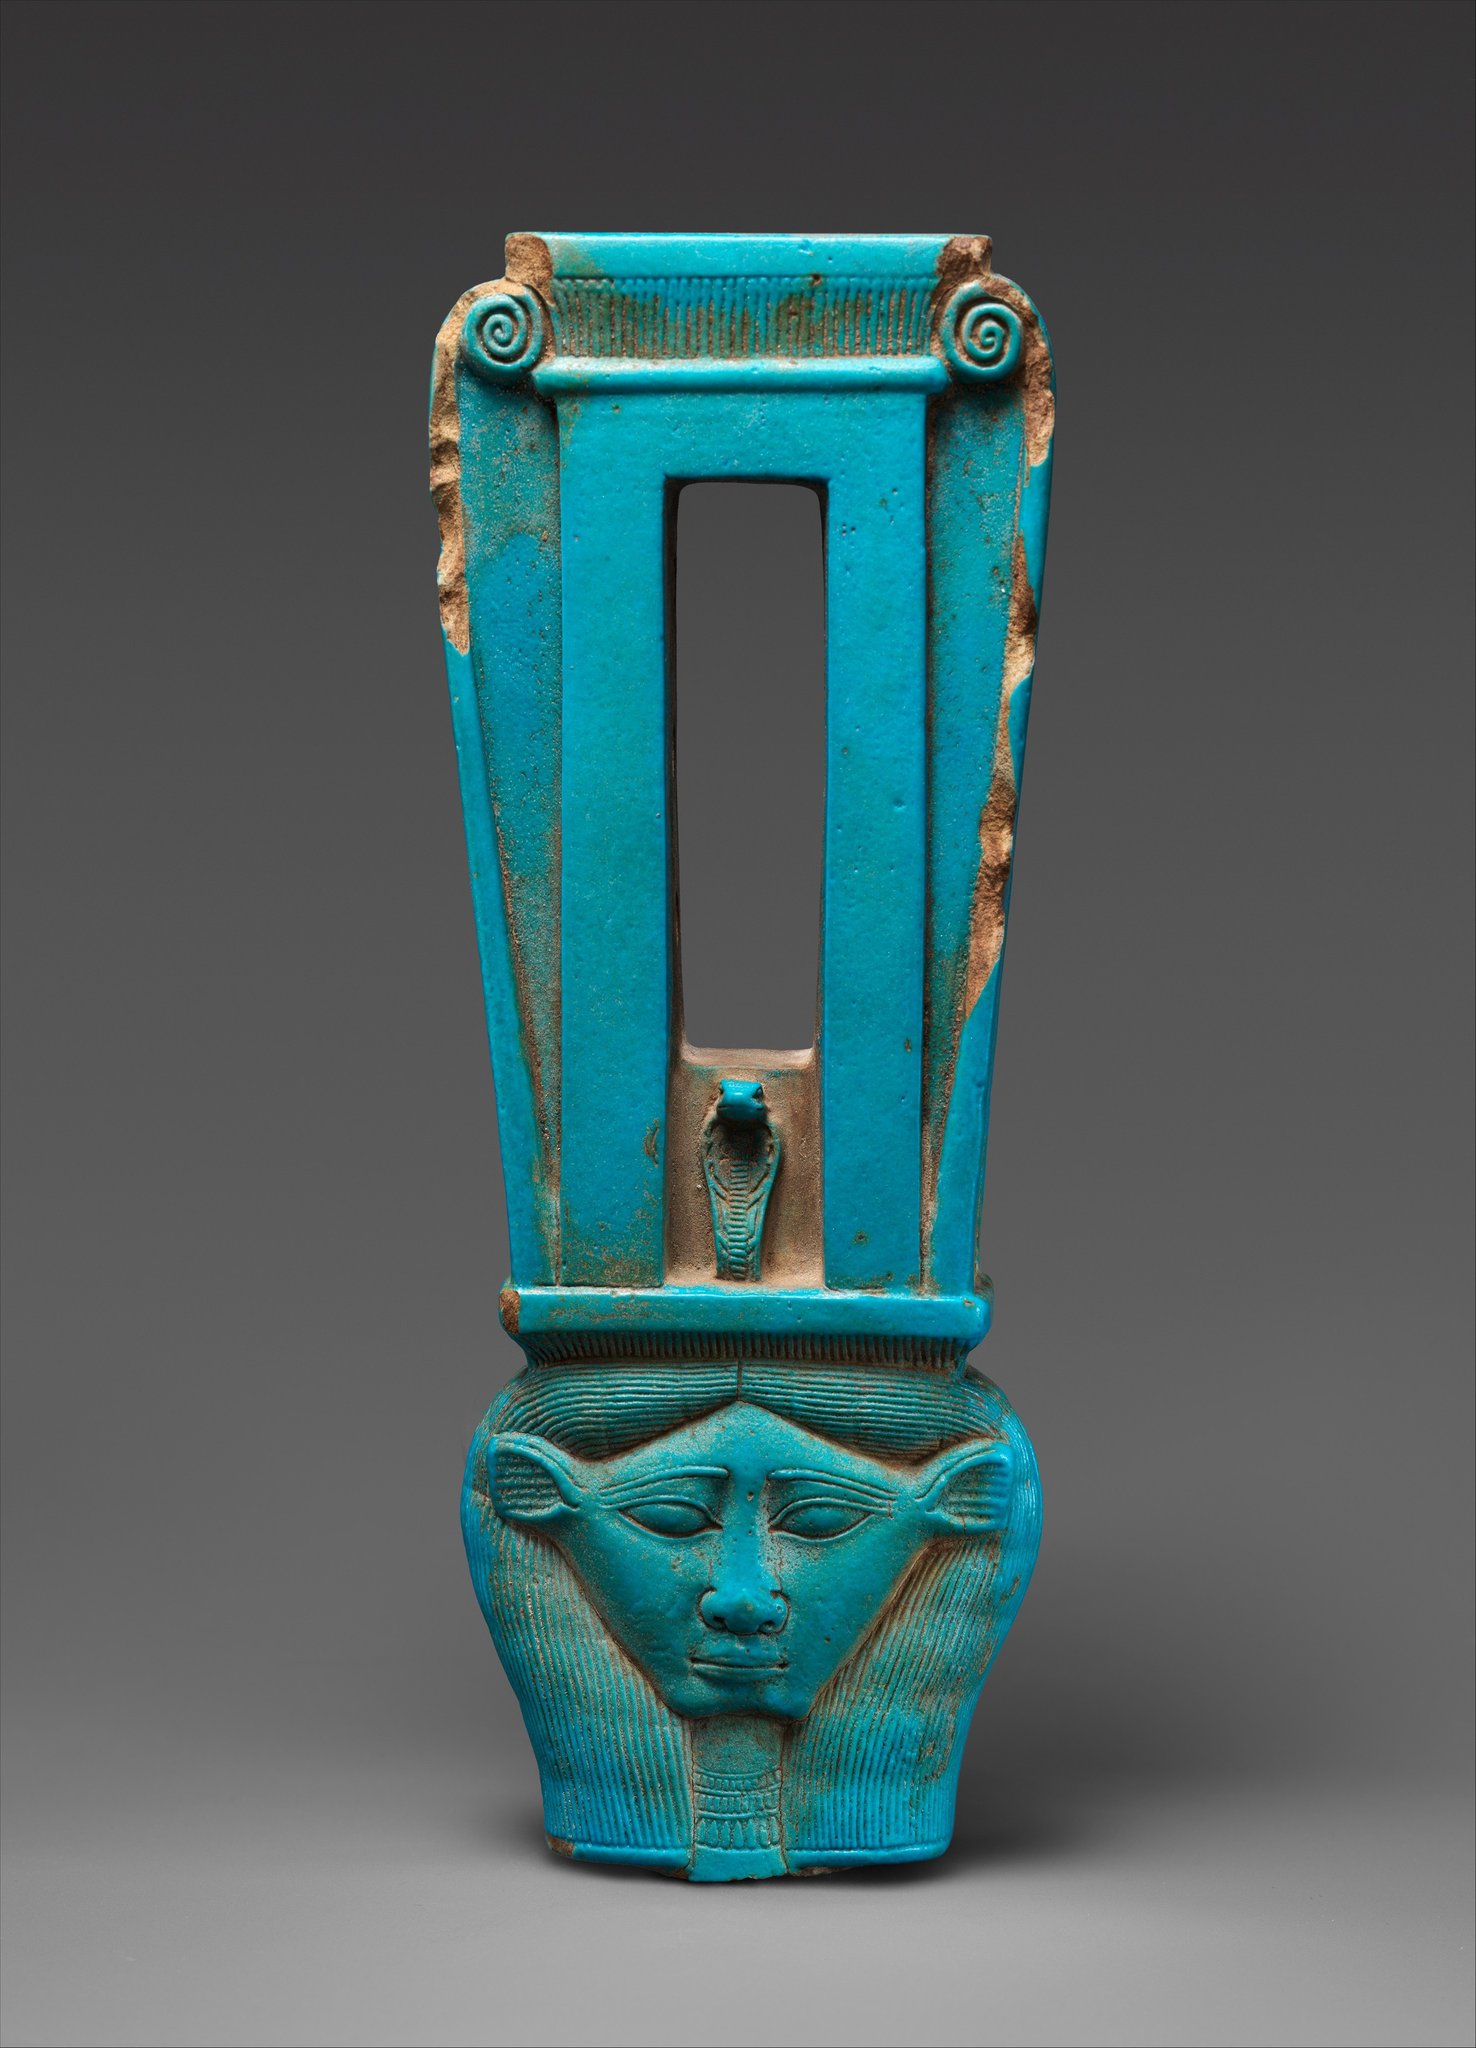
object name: music, sistrum, hathor emblem, bat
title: Upper part of a naos sistrum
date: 750-525 BCE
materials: faience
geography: egypt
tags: hathor